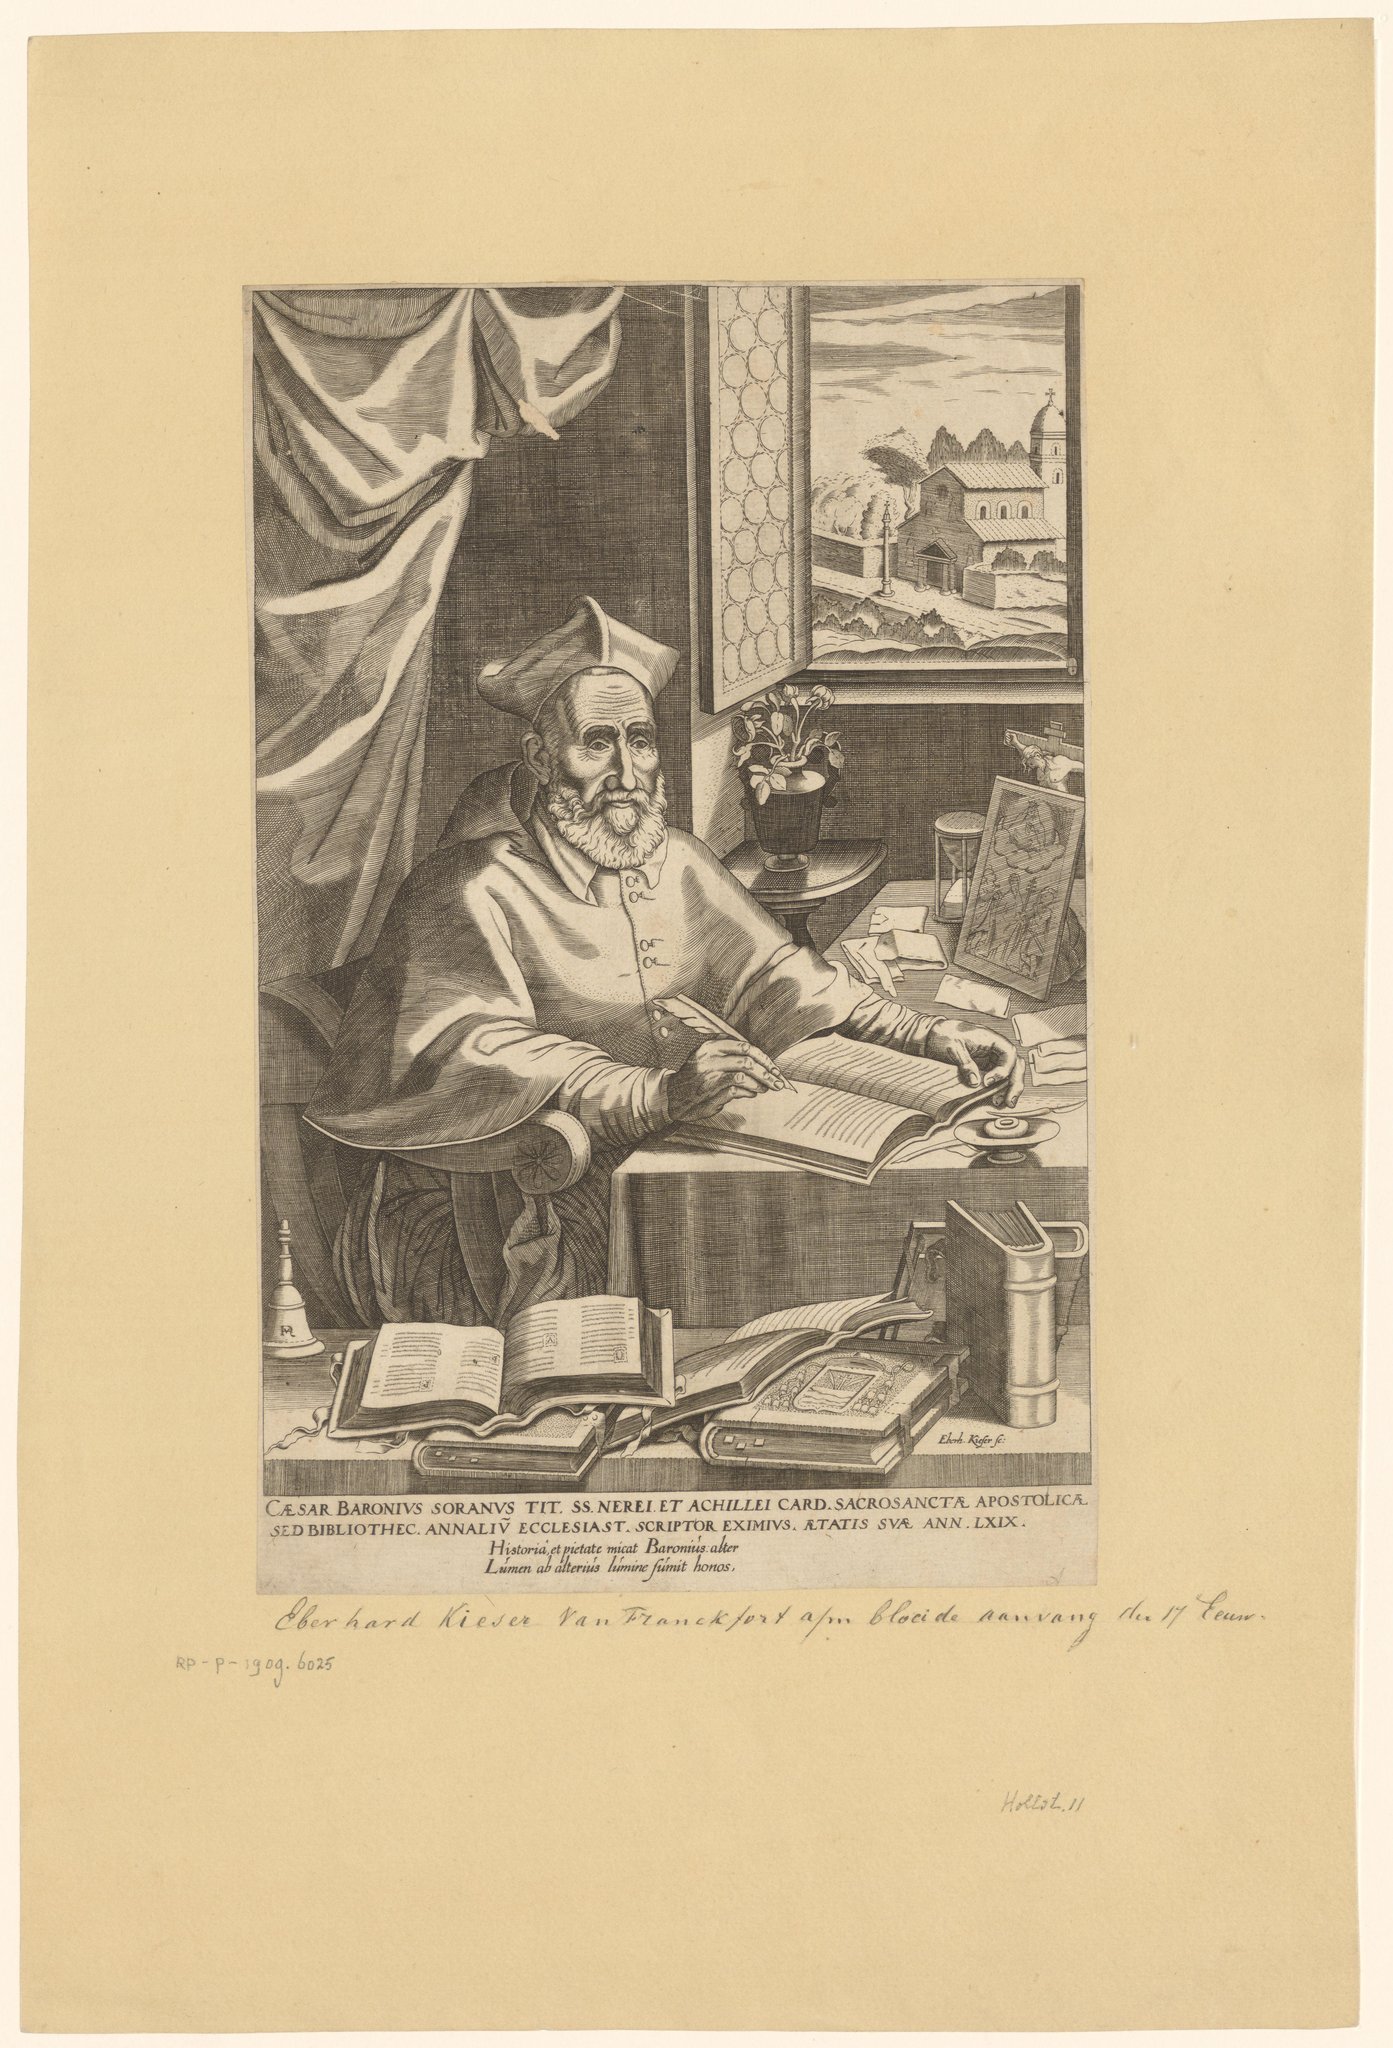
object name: print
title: Portret van Cesare Baronio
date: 1593-1625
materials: paper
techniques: engraving, etching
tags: history and archaeology (+ portrait of scholar, scientist), historical persons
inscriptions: collector's mark: Lugt 2228